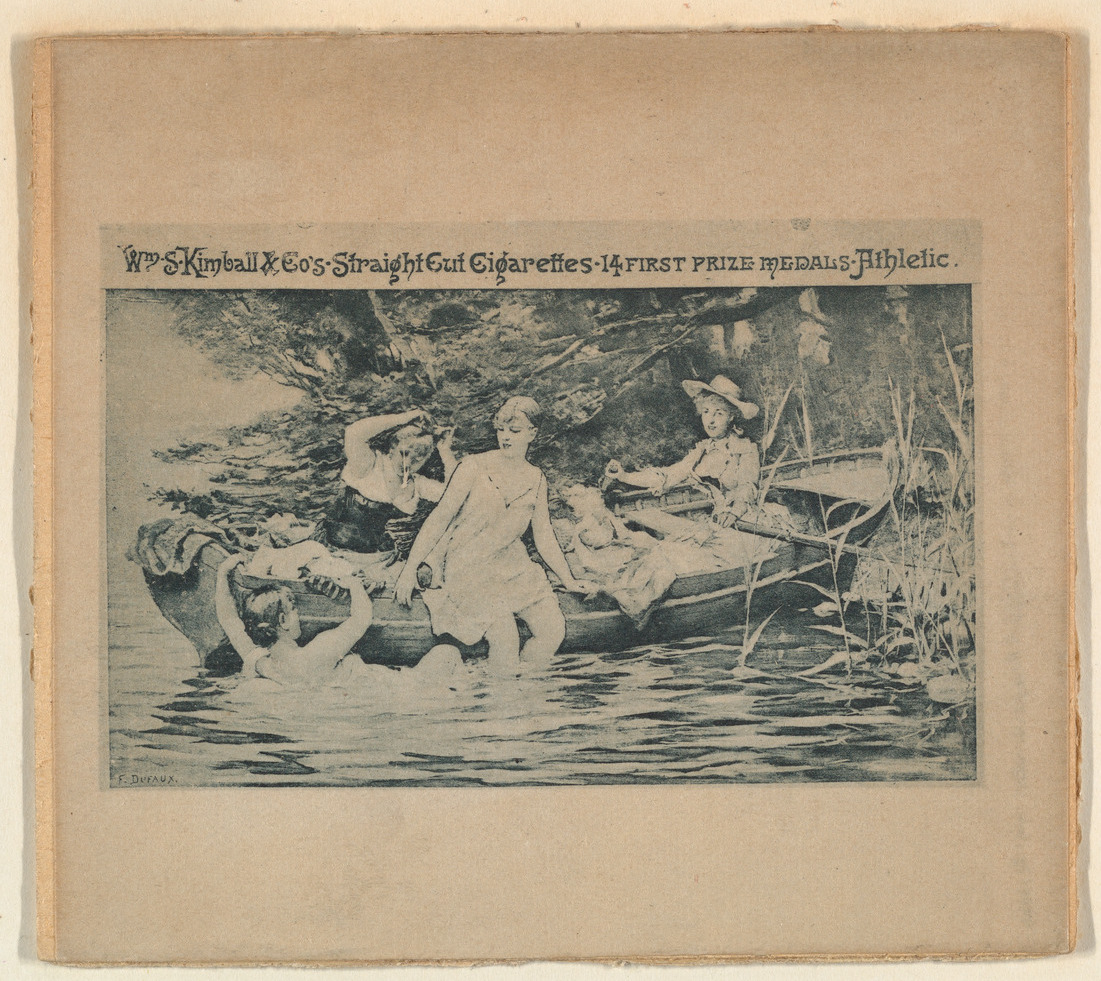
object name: print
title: Athletic, from the Sports and Art Subjects series (N197) issued by Wm. S. Kimball & Co.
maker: william s. kimball & company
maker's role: publisher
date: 1889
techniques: color lithograph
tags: women,boats